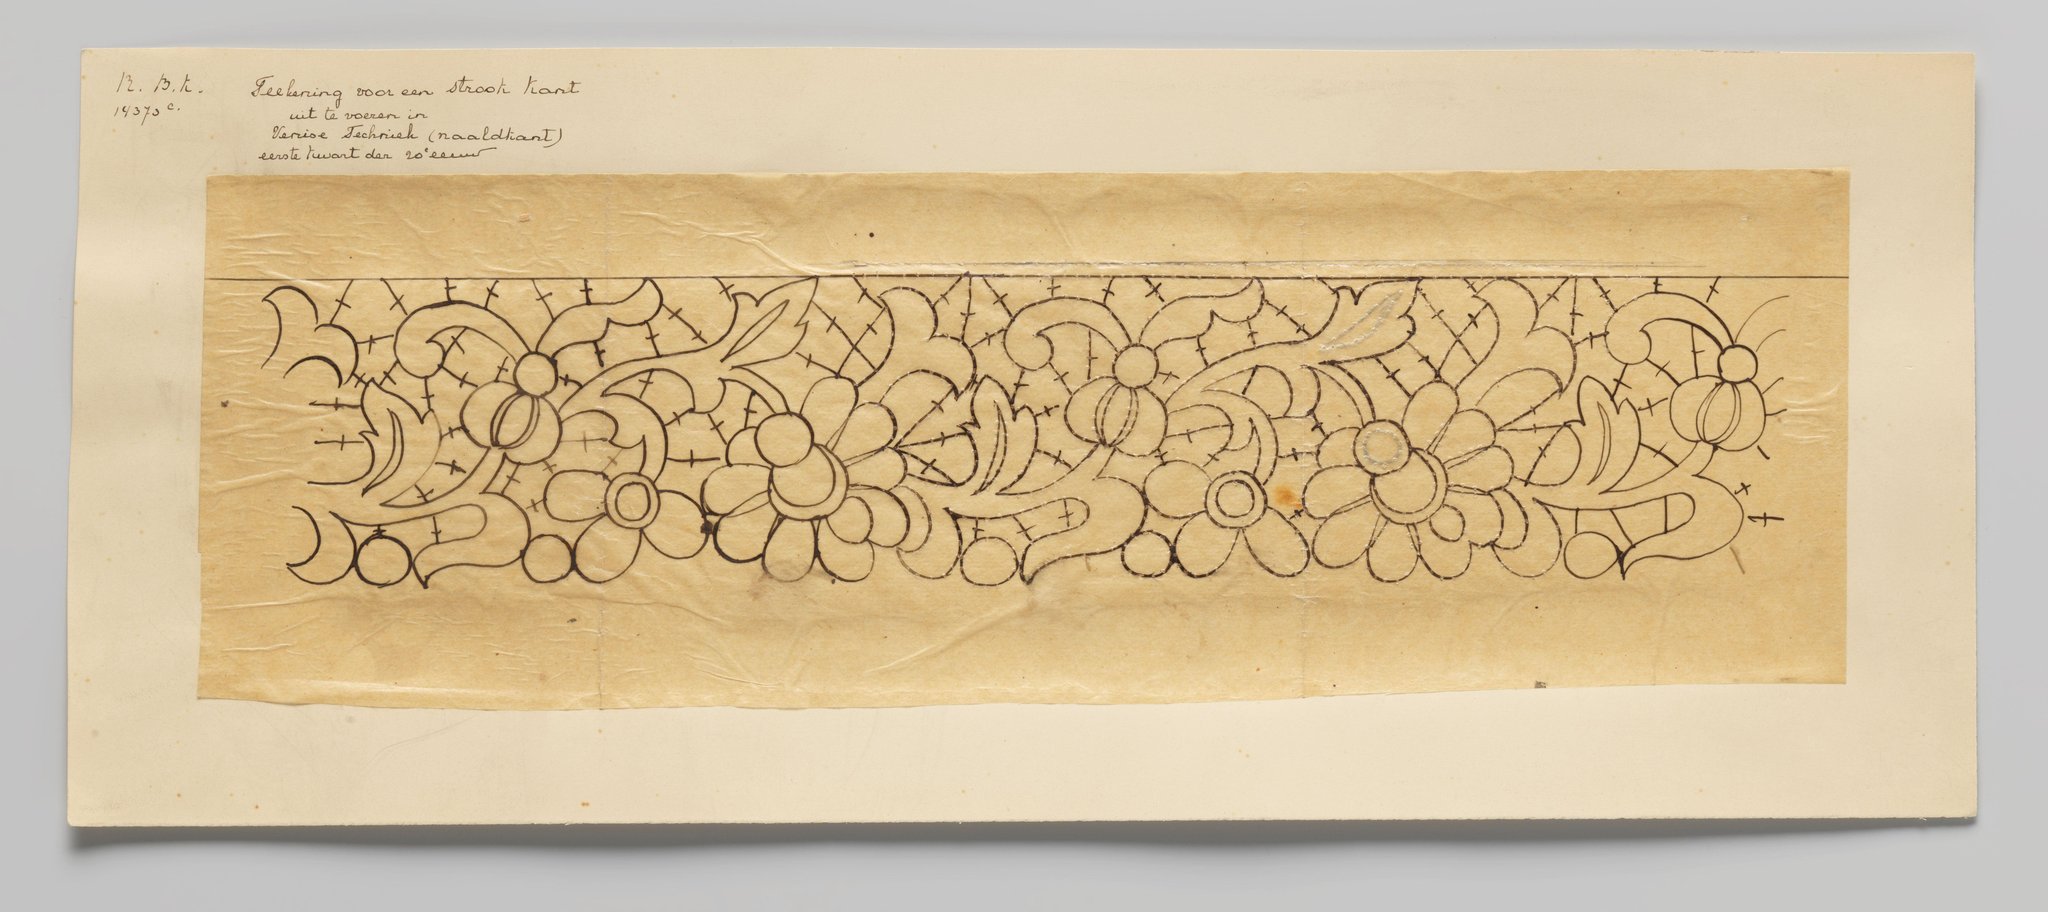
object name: lace pattern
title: Prikking met patroontekening voor een strook naaldkant met bloemen aan golvende stelen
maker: Anonymous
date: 1900-1924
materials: paper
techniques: drawing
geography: netherlands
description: Prikking met patroontekening voor het maken van een strook Venetiaanse naaldkant. Het naaldkantpatroon is met inkt getekend op transparant papier en langs de patroonlijnen zijn vervolgens gaatjes geprikt. De prikking is daarna op een karton geplakt. Het patroon bestaat uit bloemen aan golvende stelen, die met elkaar verbonden zijn door een spijlengrond met picots.